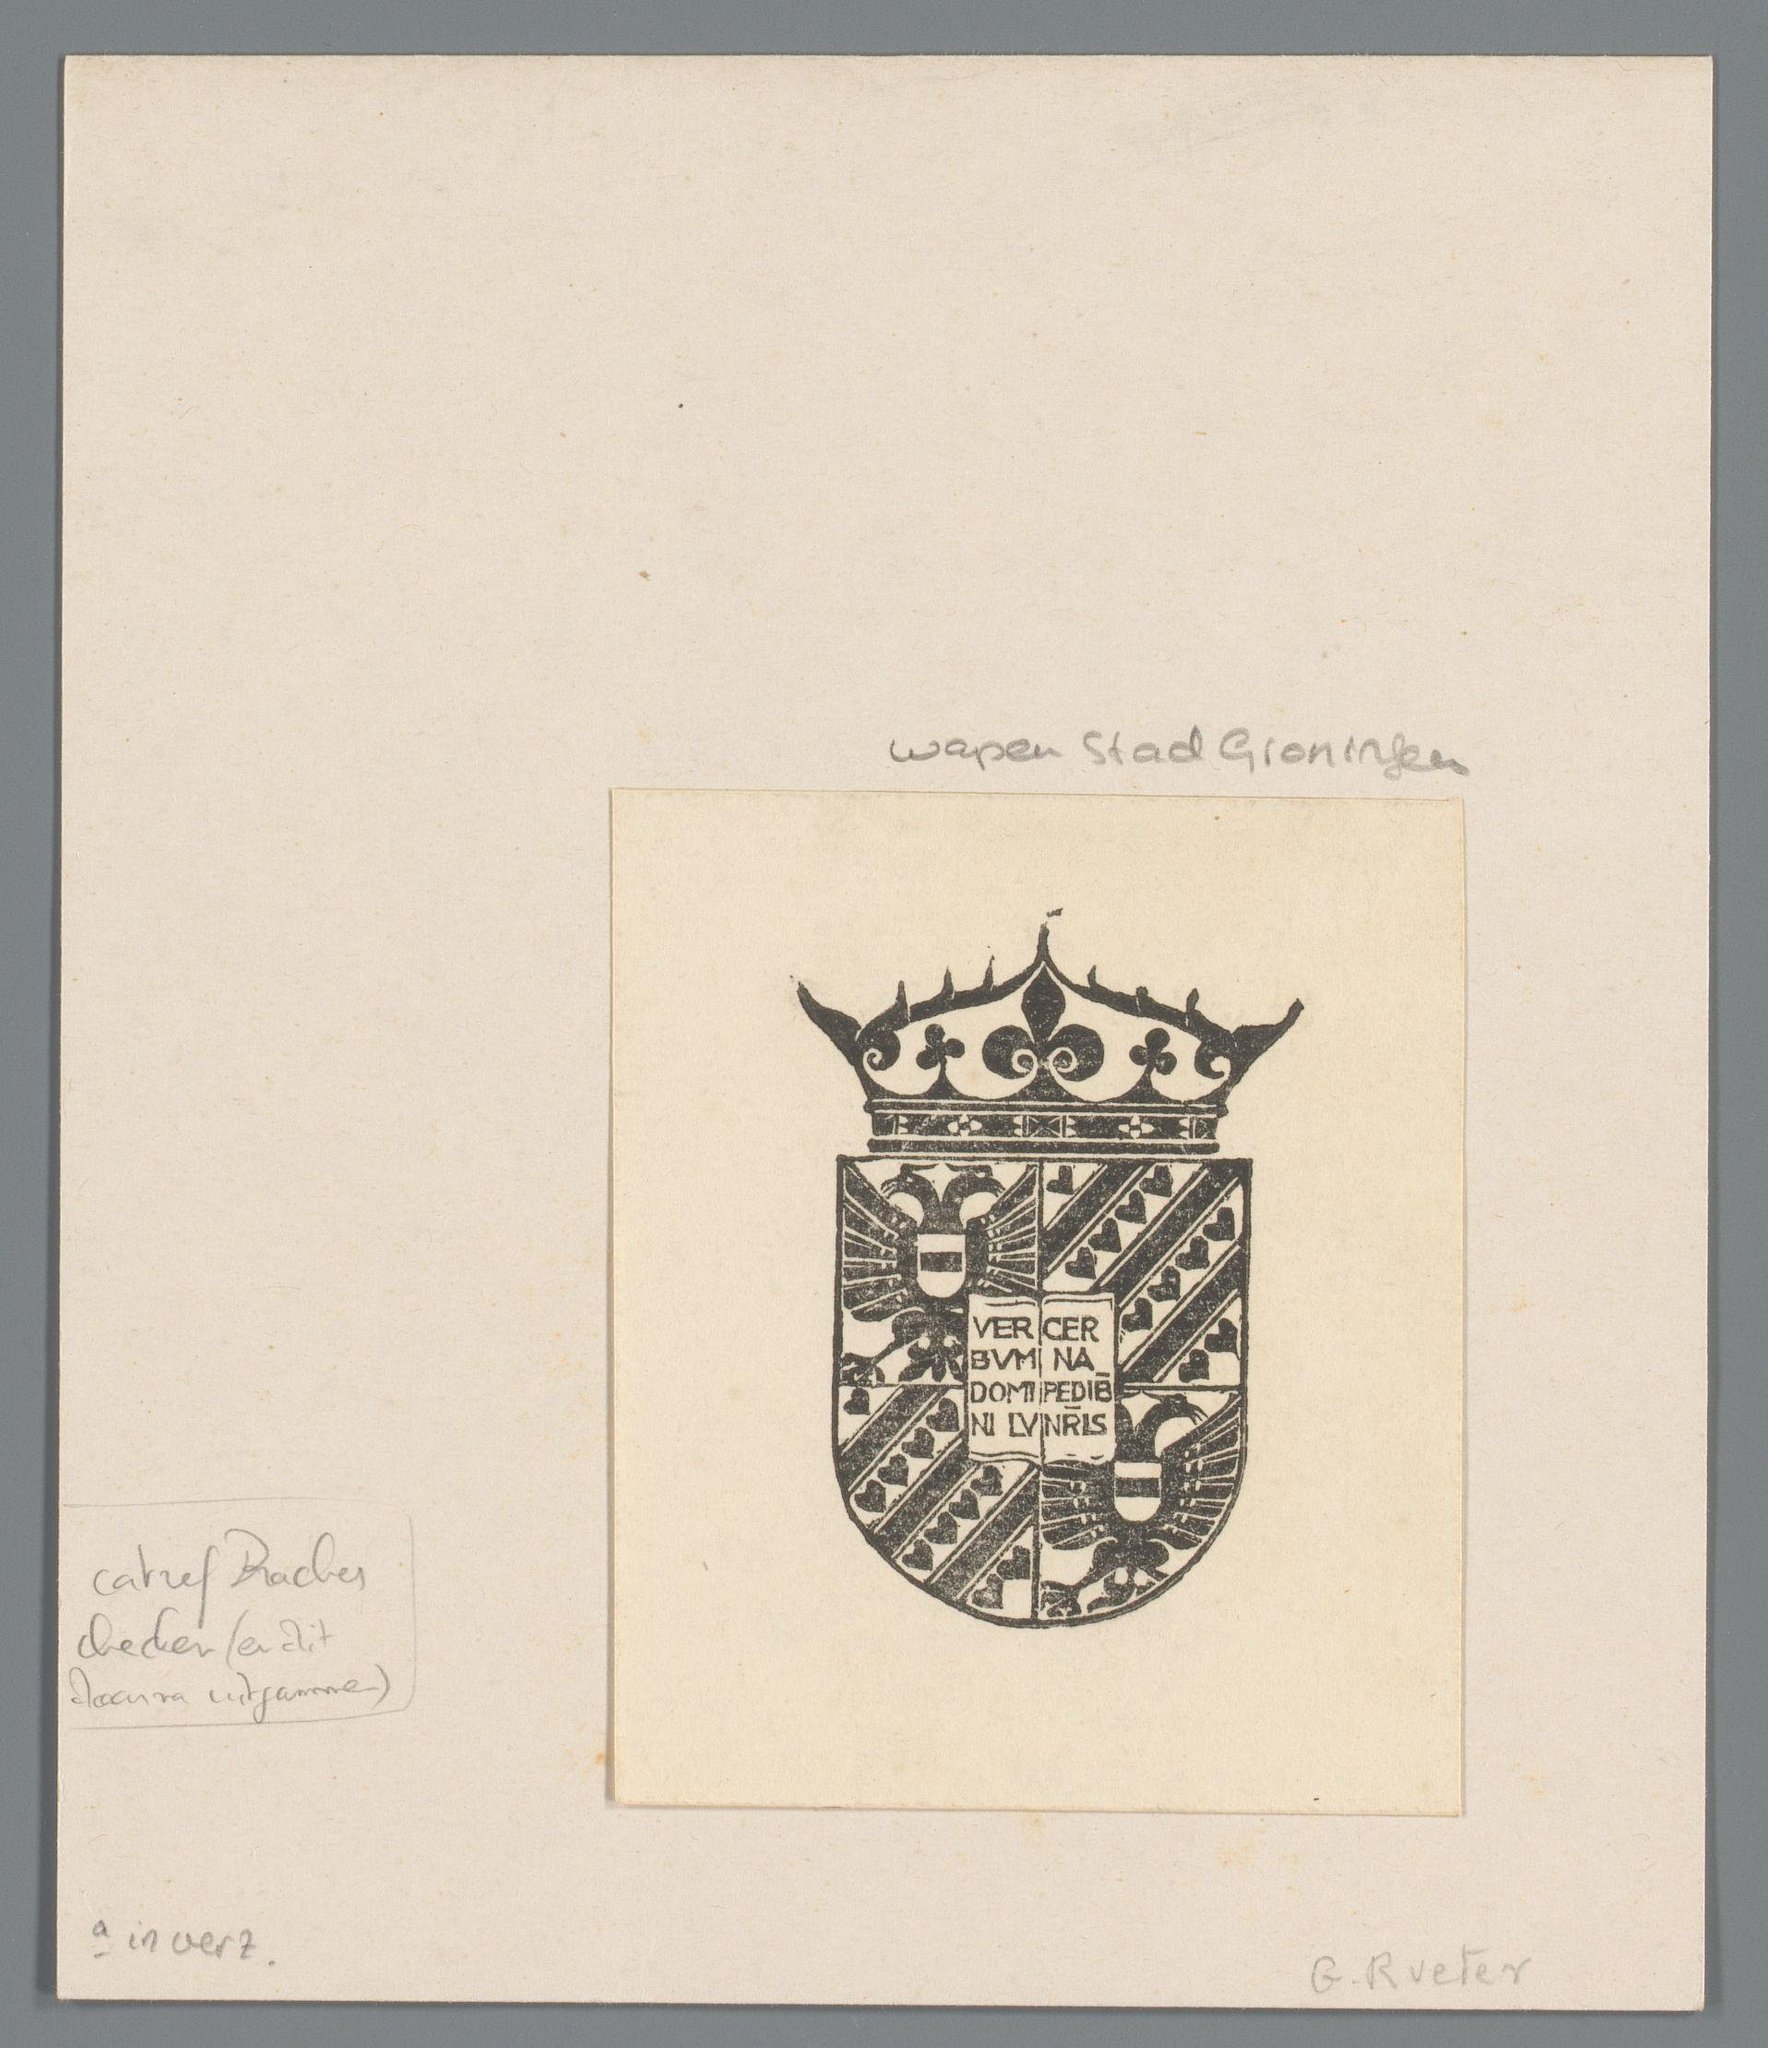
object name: print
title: Wapen van de Rijksuniversiteit Groningen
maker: georg rueter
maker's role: draughtsman, painter, print maker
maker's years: 1875-1966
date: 1885-1966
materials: paper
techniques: woodcut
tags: armorial bearing, heraldry